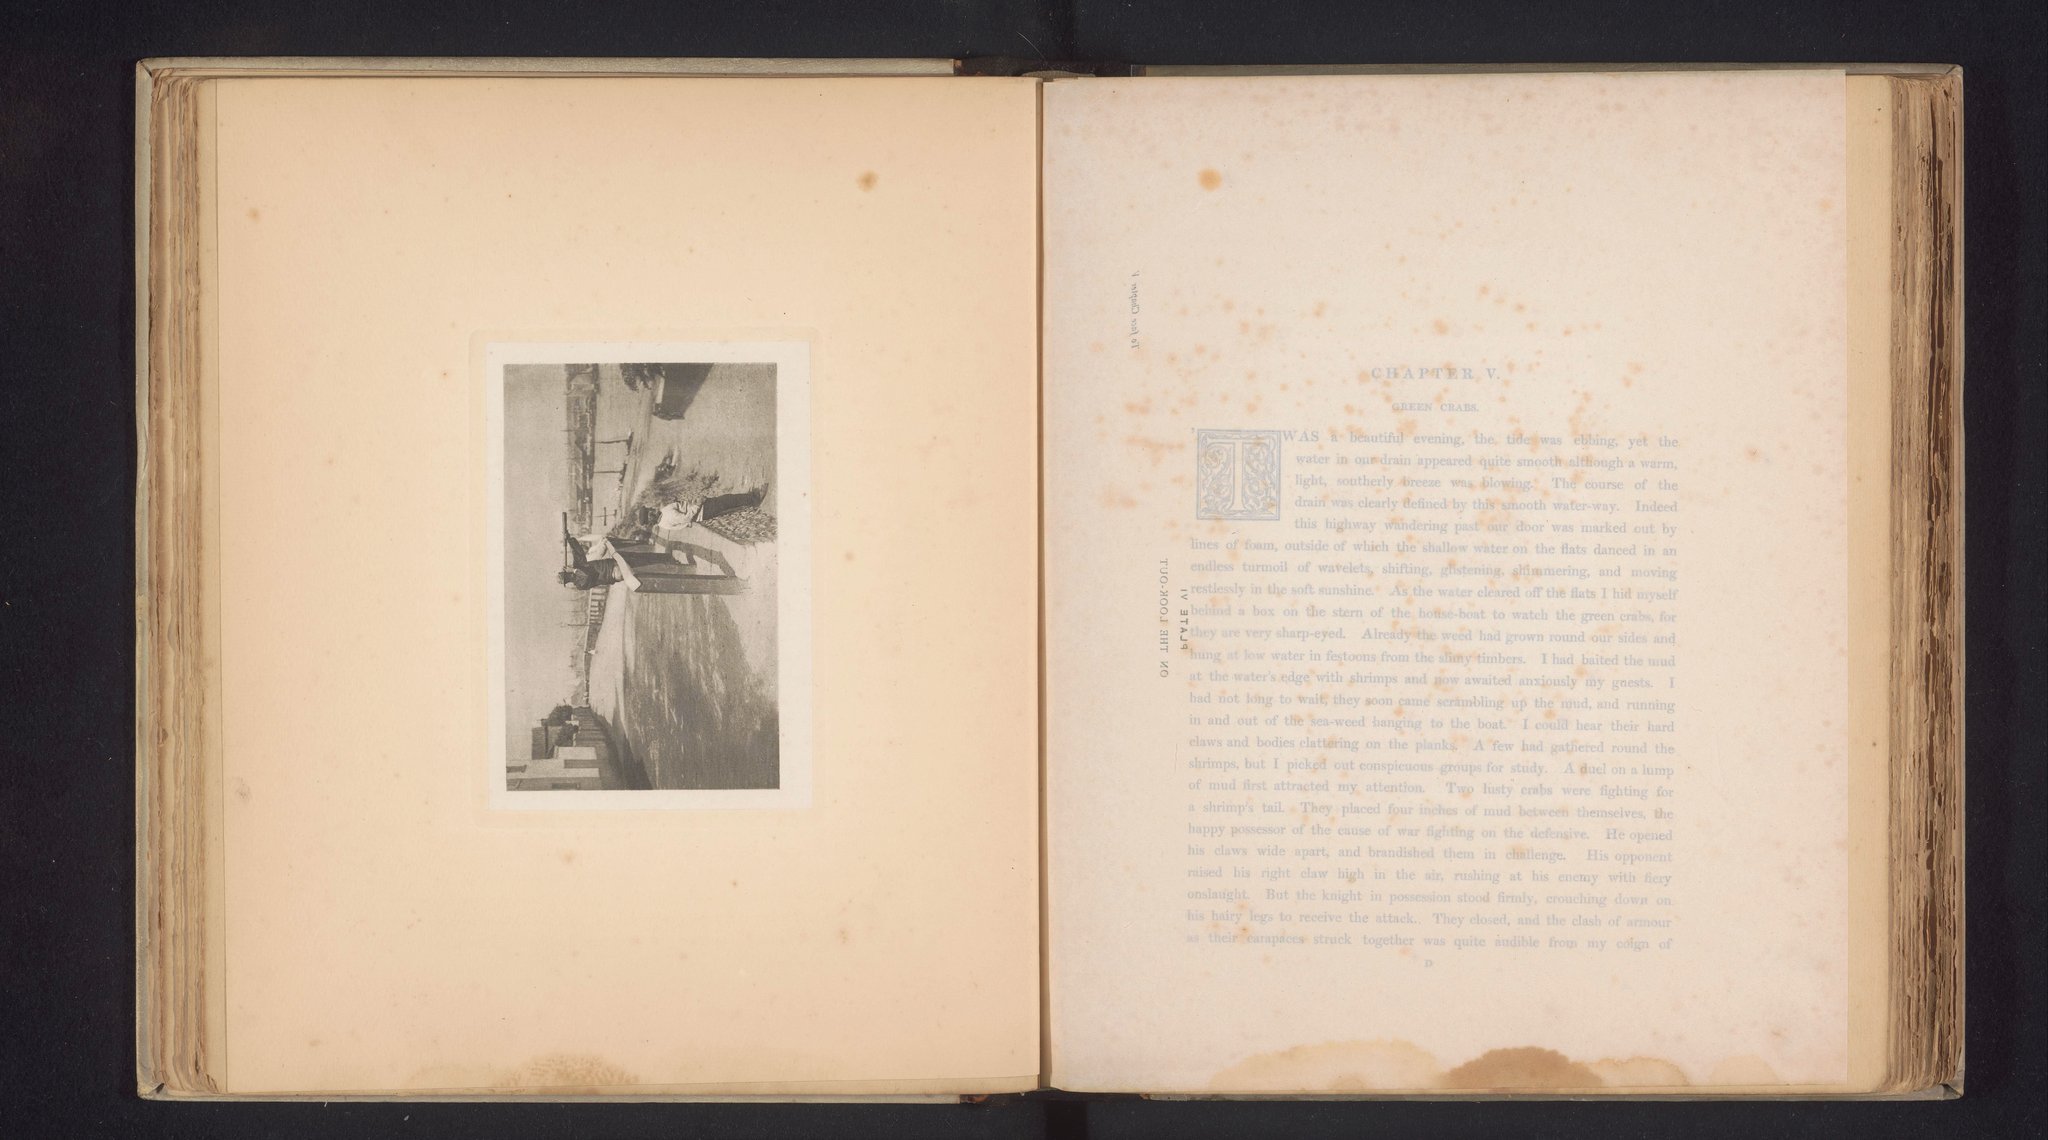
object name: photomechanical print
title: Man met een telescoop langs een kade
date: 1880-1890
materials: paper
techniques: photoaquatint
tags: adult man, telescope, quay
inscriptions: number: ‘Plate VI’, inscription: ‘On the look-out’